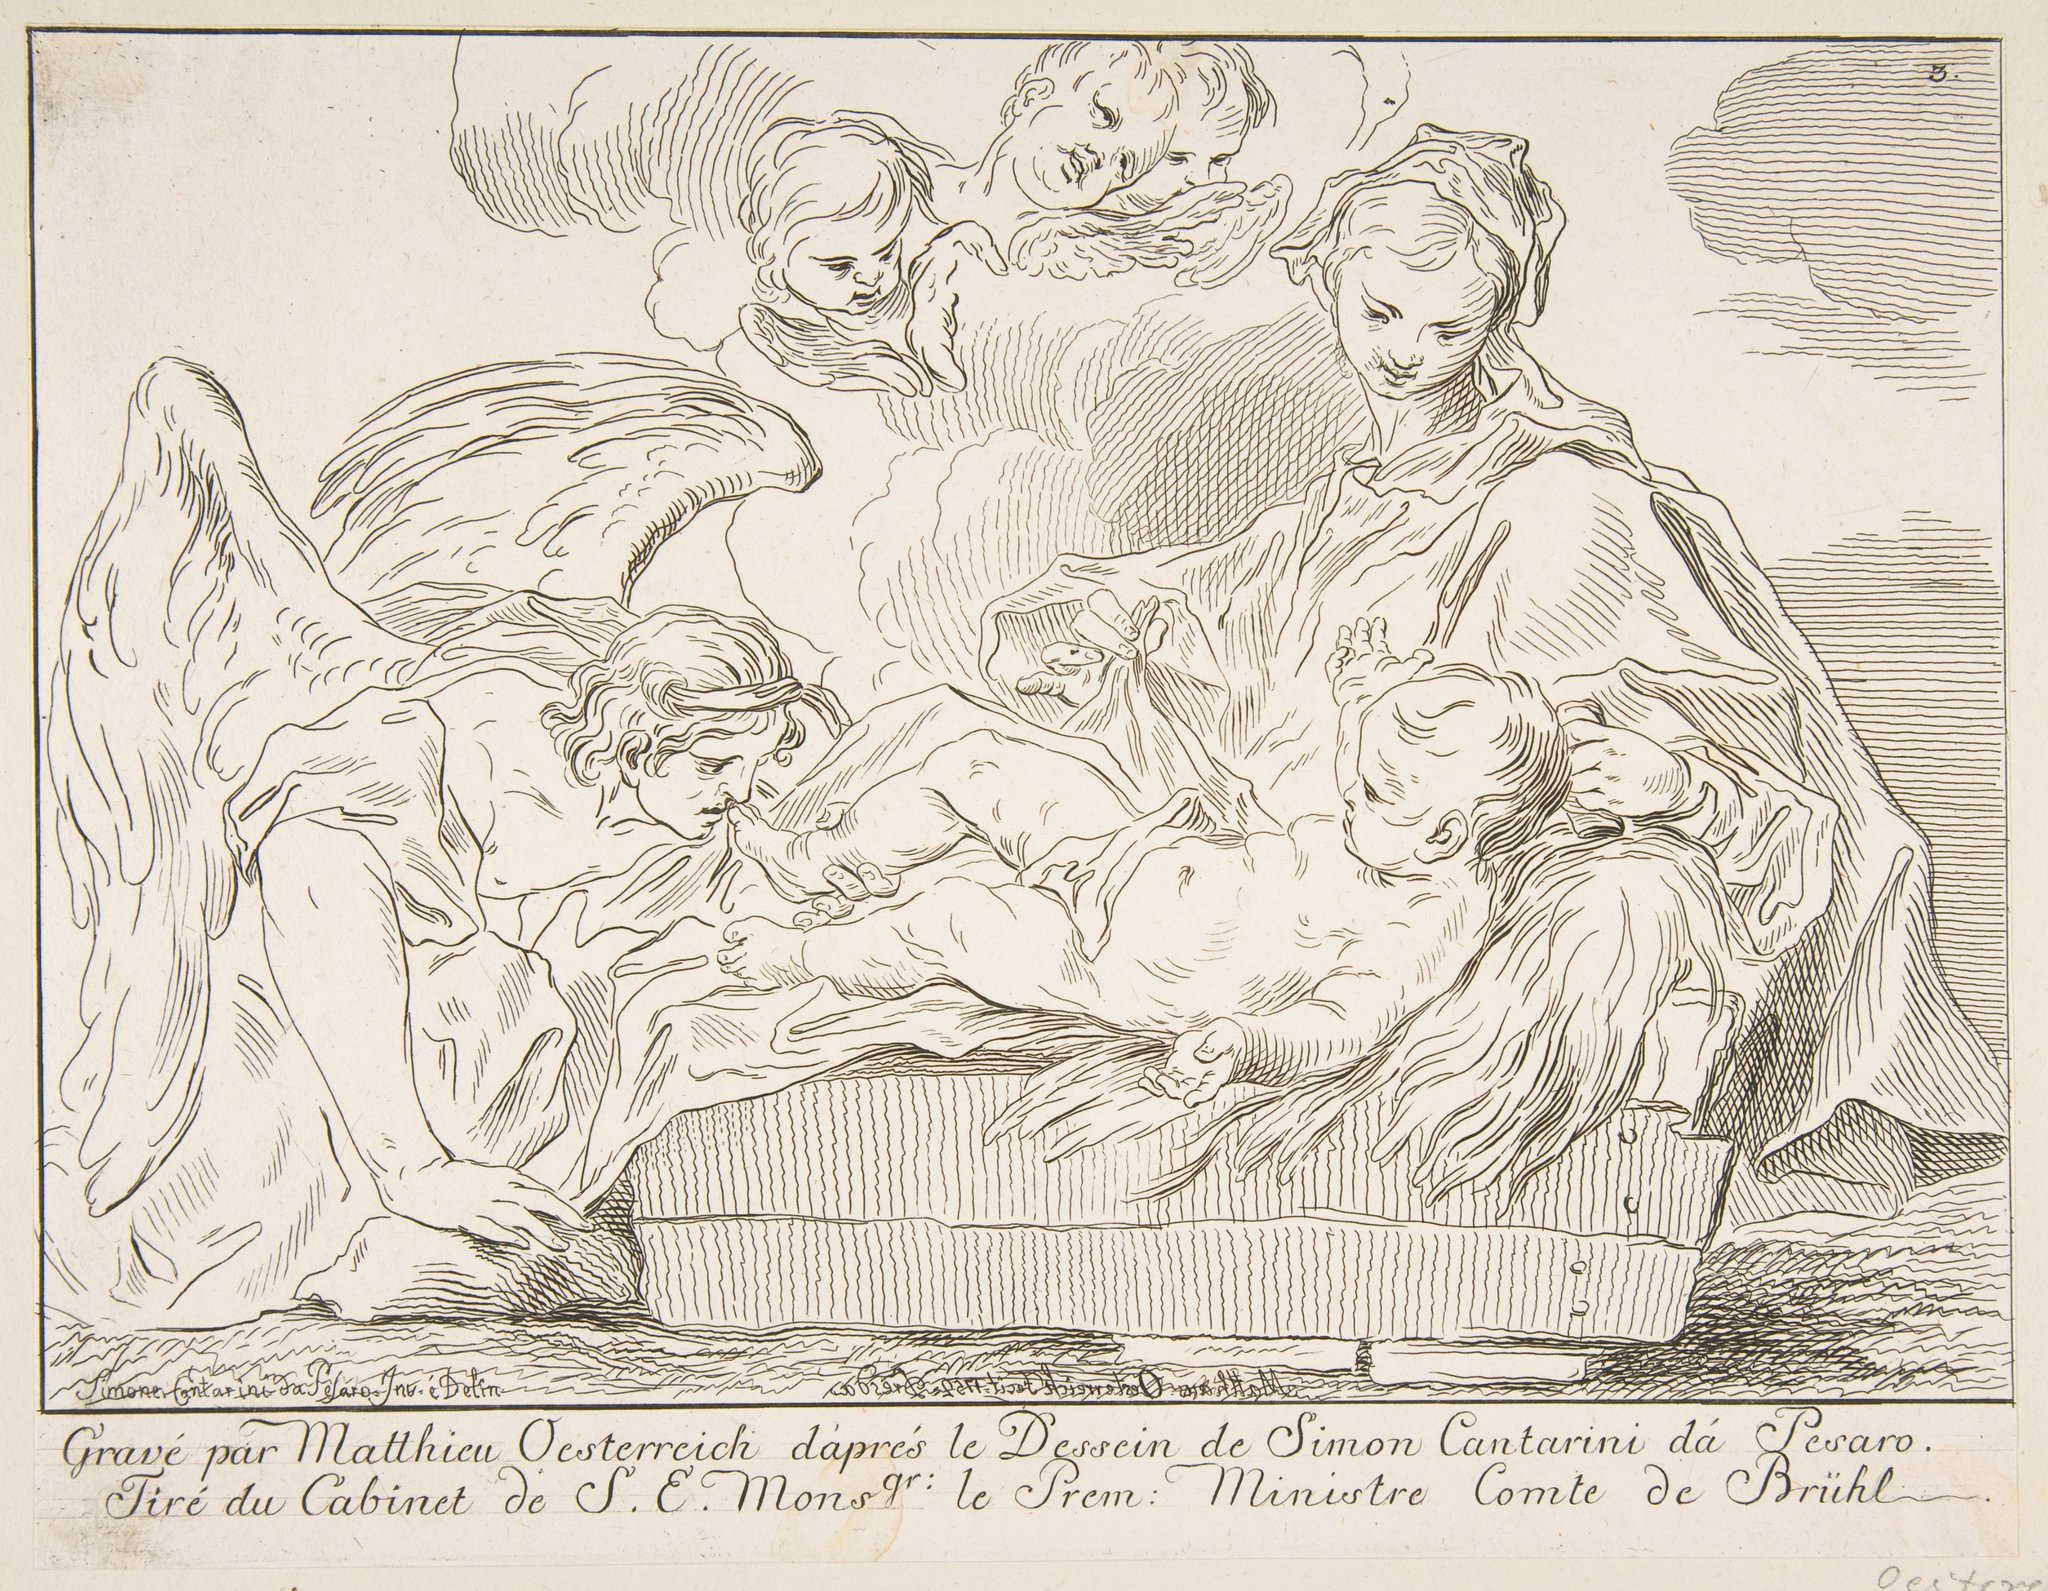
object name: print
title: Virgin and Child with an angel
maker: matthias oesterreich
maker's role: artist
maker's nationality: german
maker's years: 1716-1778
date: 1752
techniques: etching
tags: angels,madonna and child